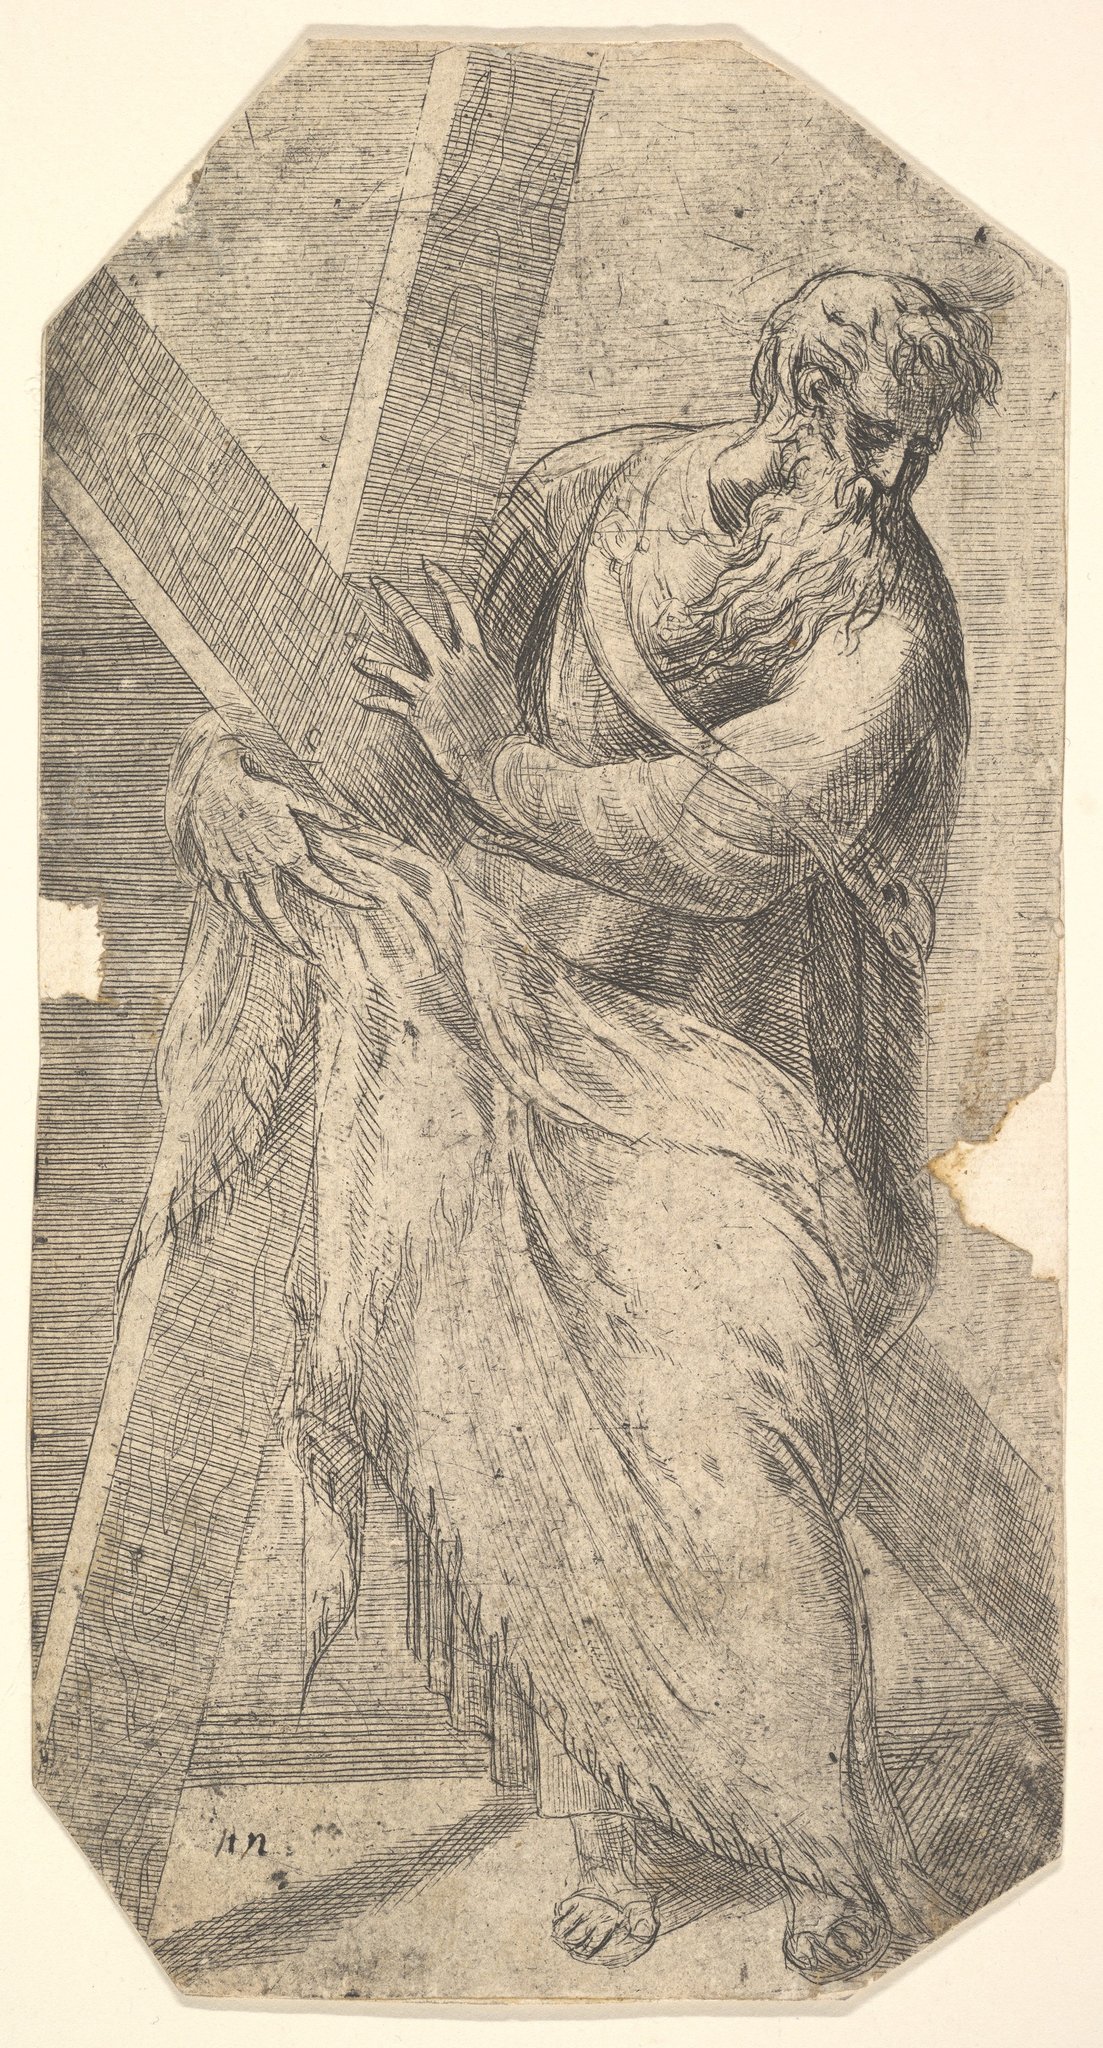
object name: print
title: Saint Andrew holding a large cross, from "Christ and the Apostles"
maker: andrea schiavone (andrea meldola)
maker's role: artist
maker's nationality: italian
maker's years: 1510-1563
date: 1548-1550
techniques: etching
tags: men,cross,saints